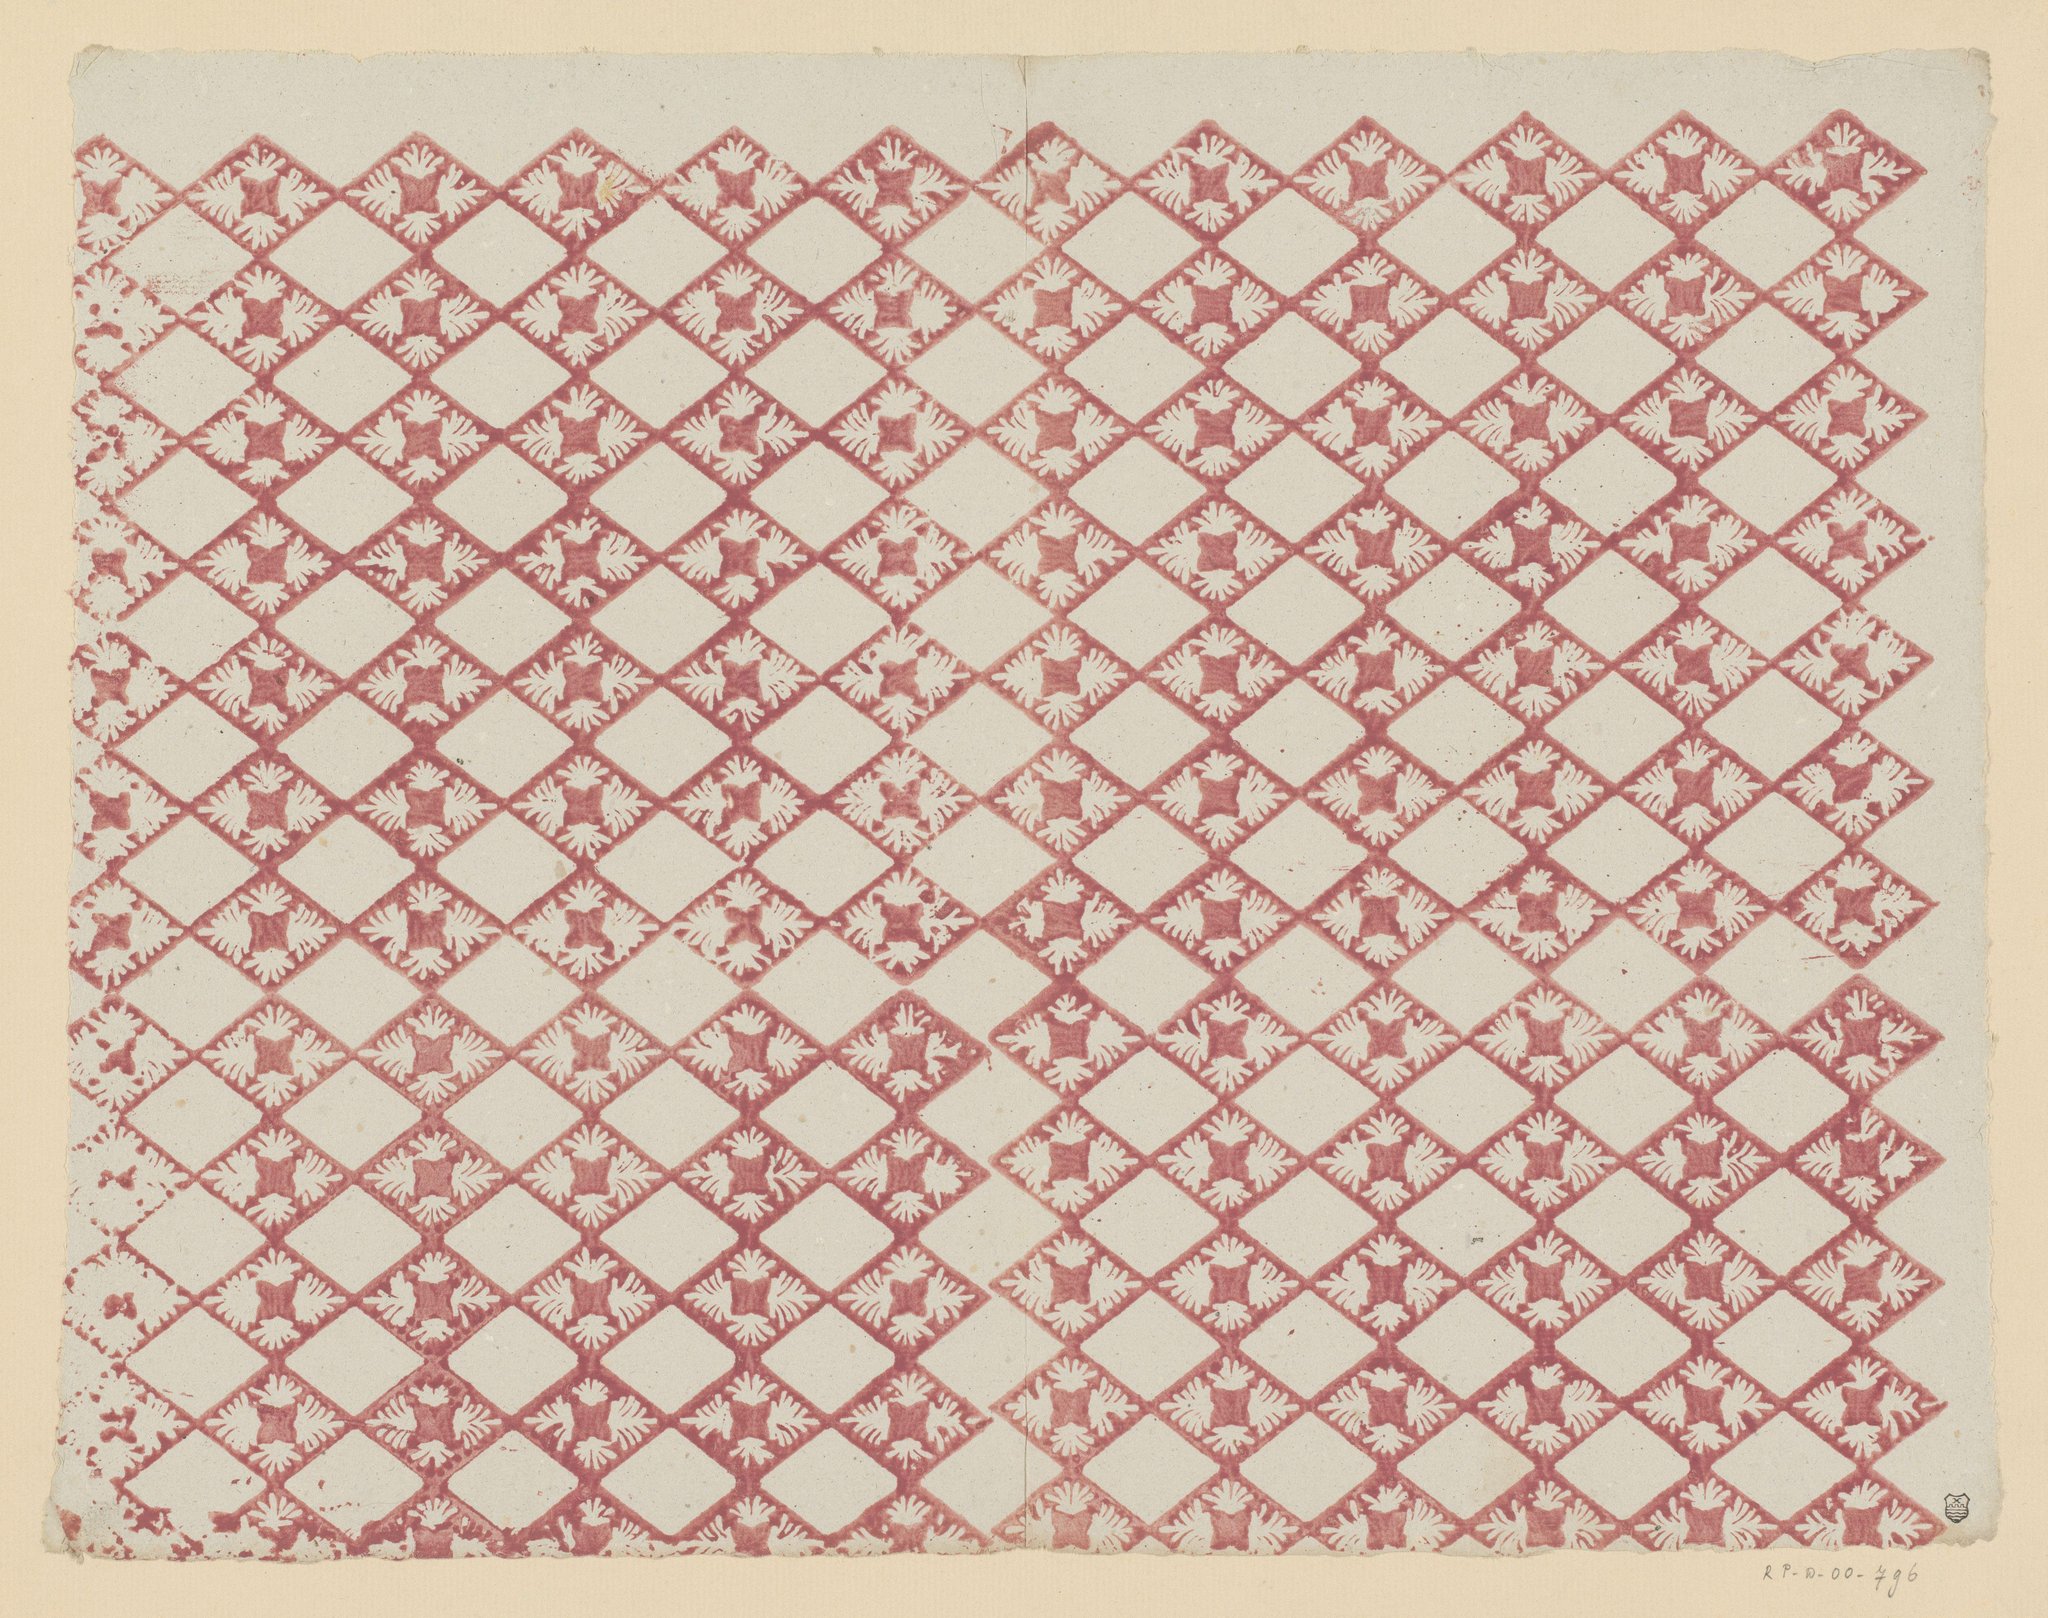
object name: printed paper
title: Blad met ruitenpatroon met bladmotief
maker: Anonymous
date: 1750-1950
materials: paper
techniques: printing block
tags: ornament derived from plant forms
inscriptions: collector's mark: Lugt 2760